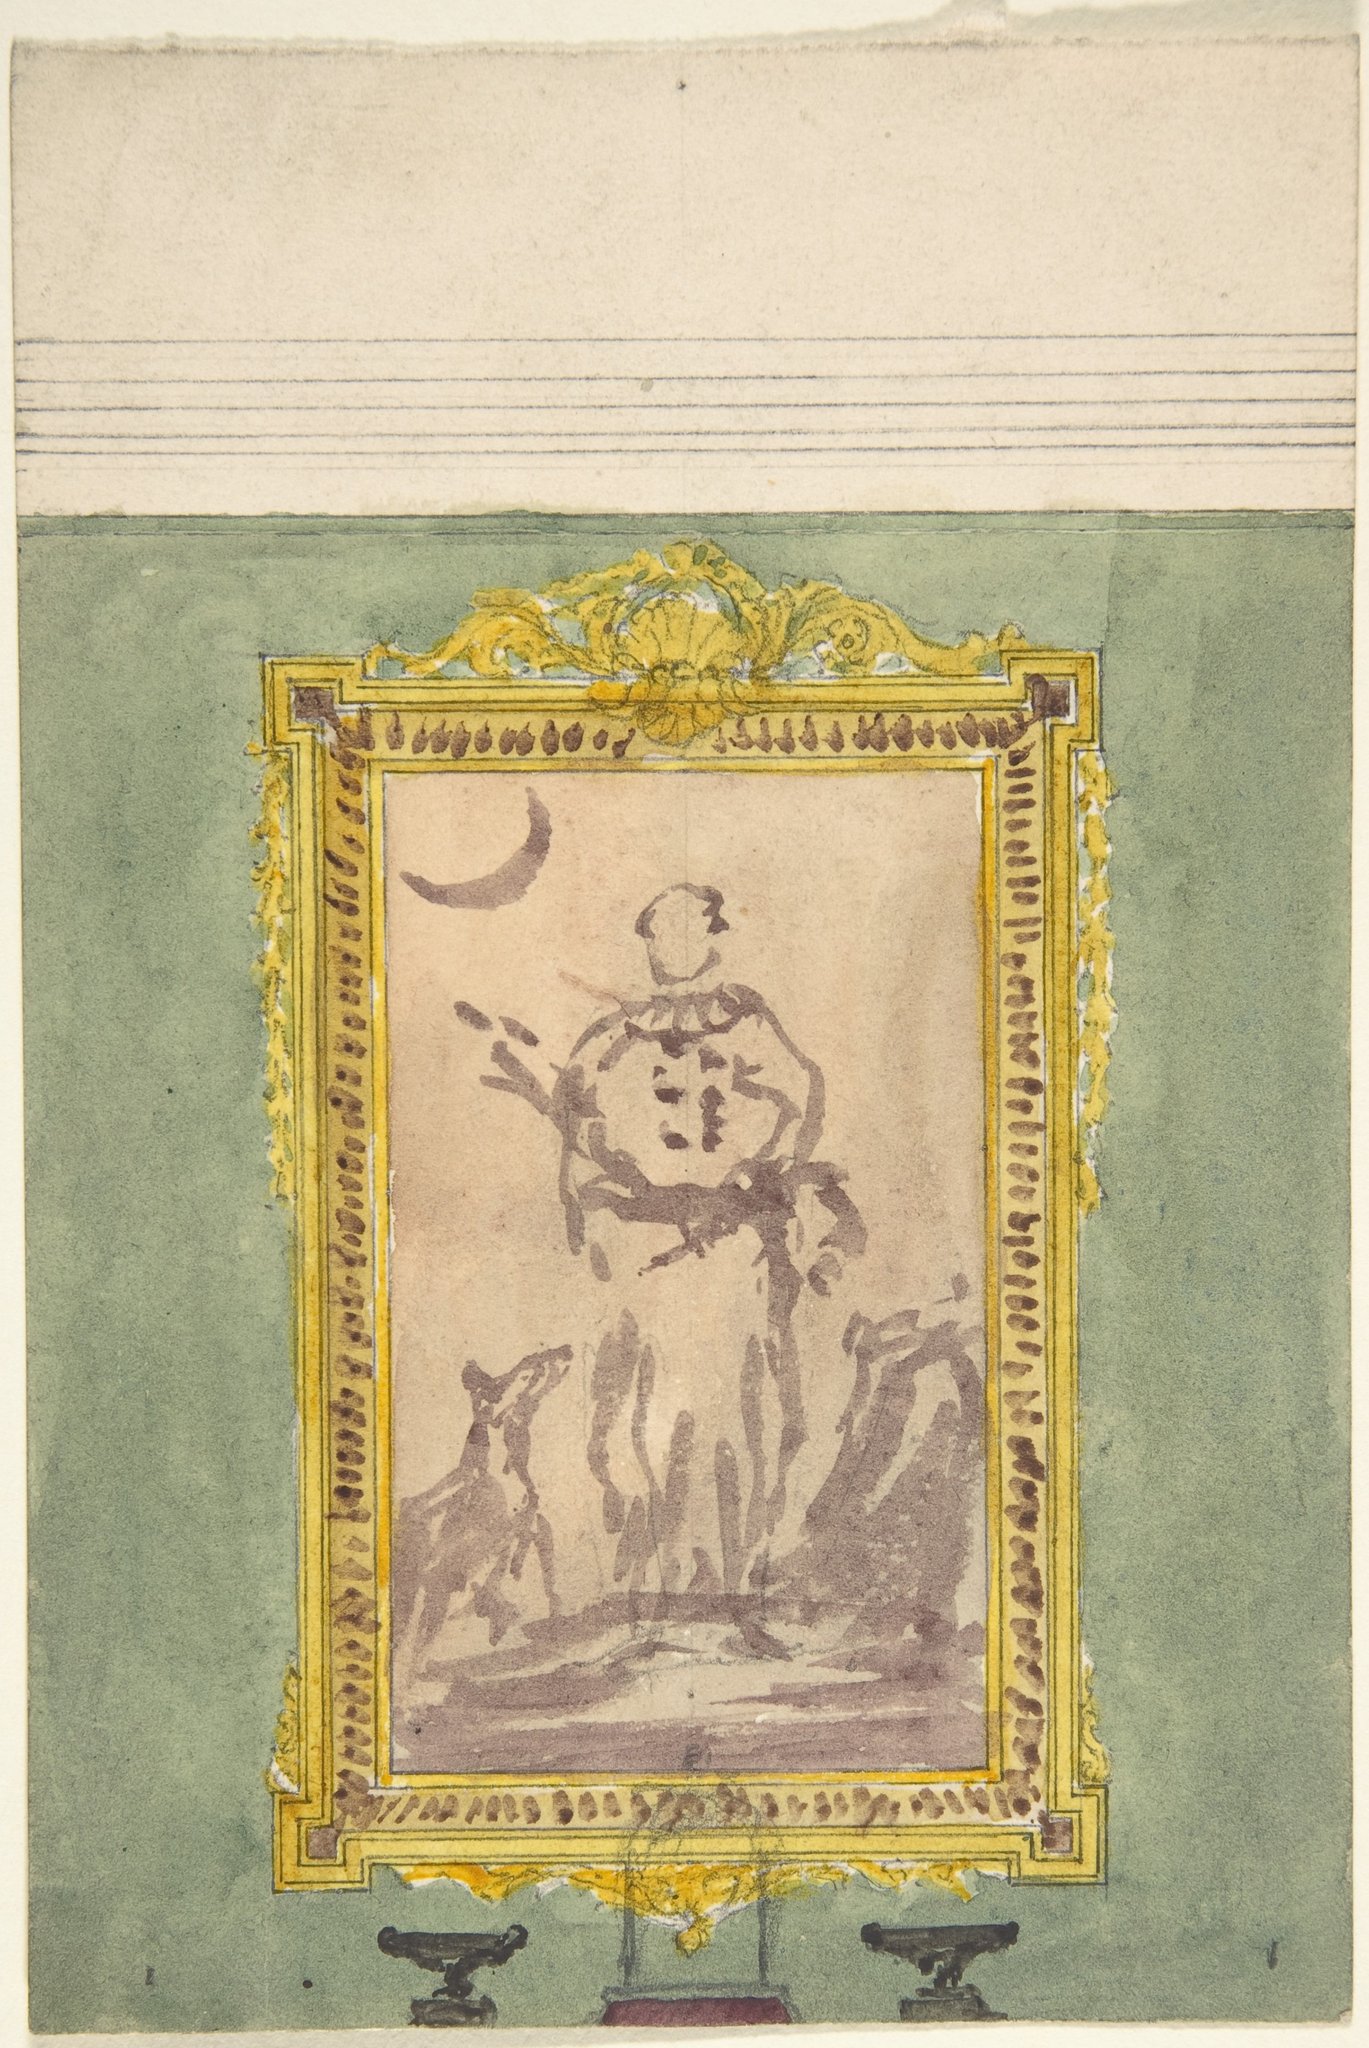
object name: drawing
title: Overmantel Picture with Diana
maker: anonymous, british, 19th century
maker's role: artist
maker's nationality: british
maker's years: 1800-1900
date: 1801-1900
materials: ink, watercolor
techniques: pen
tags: diana